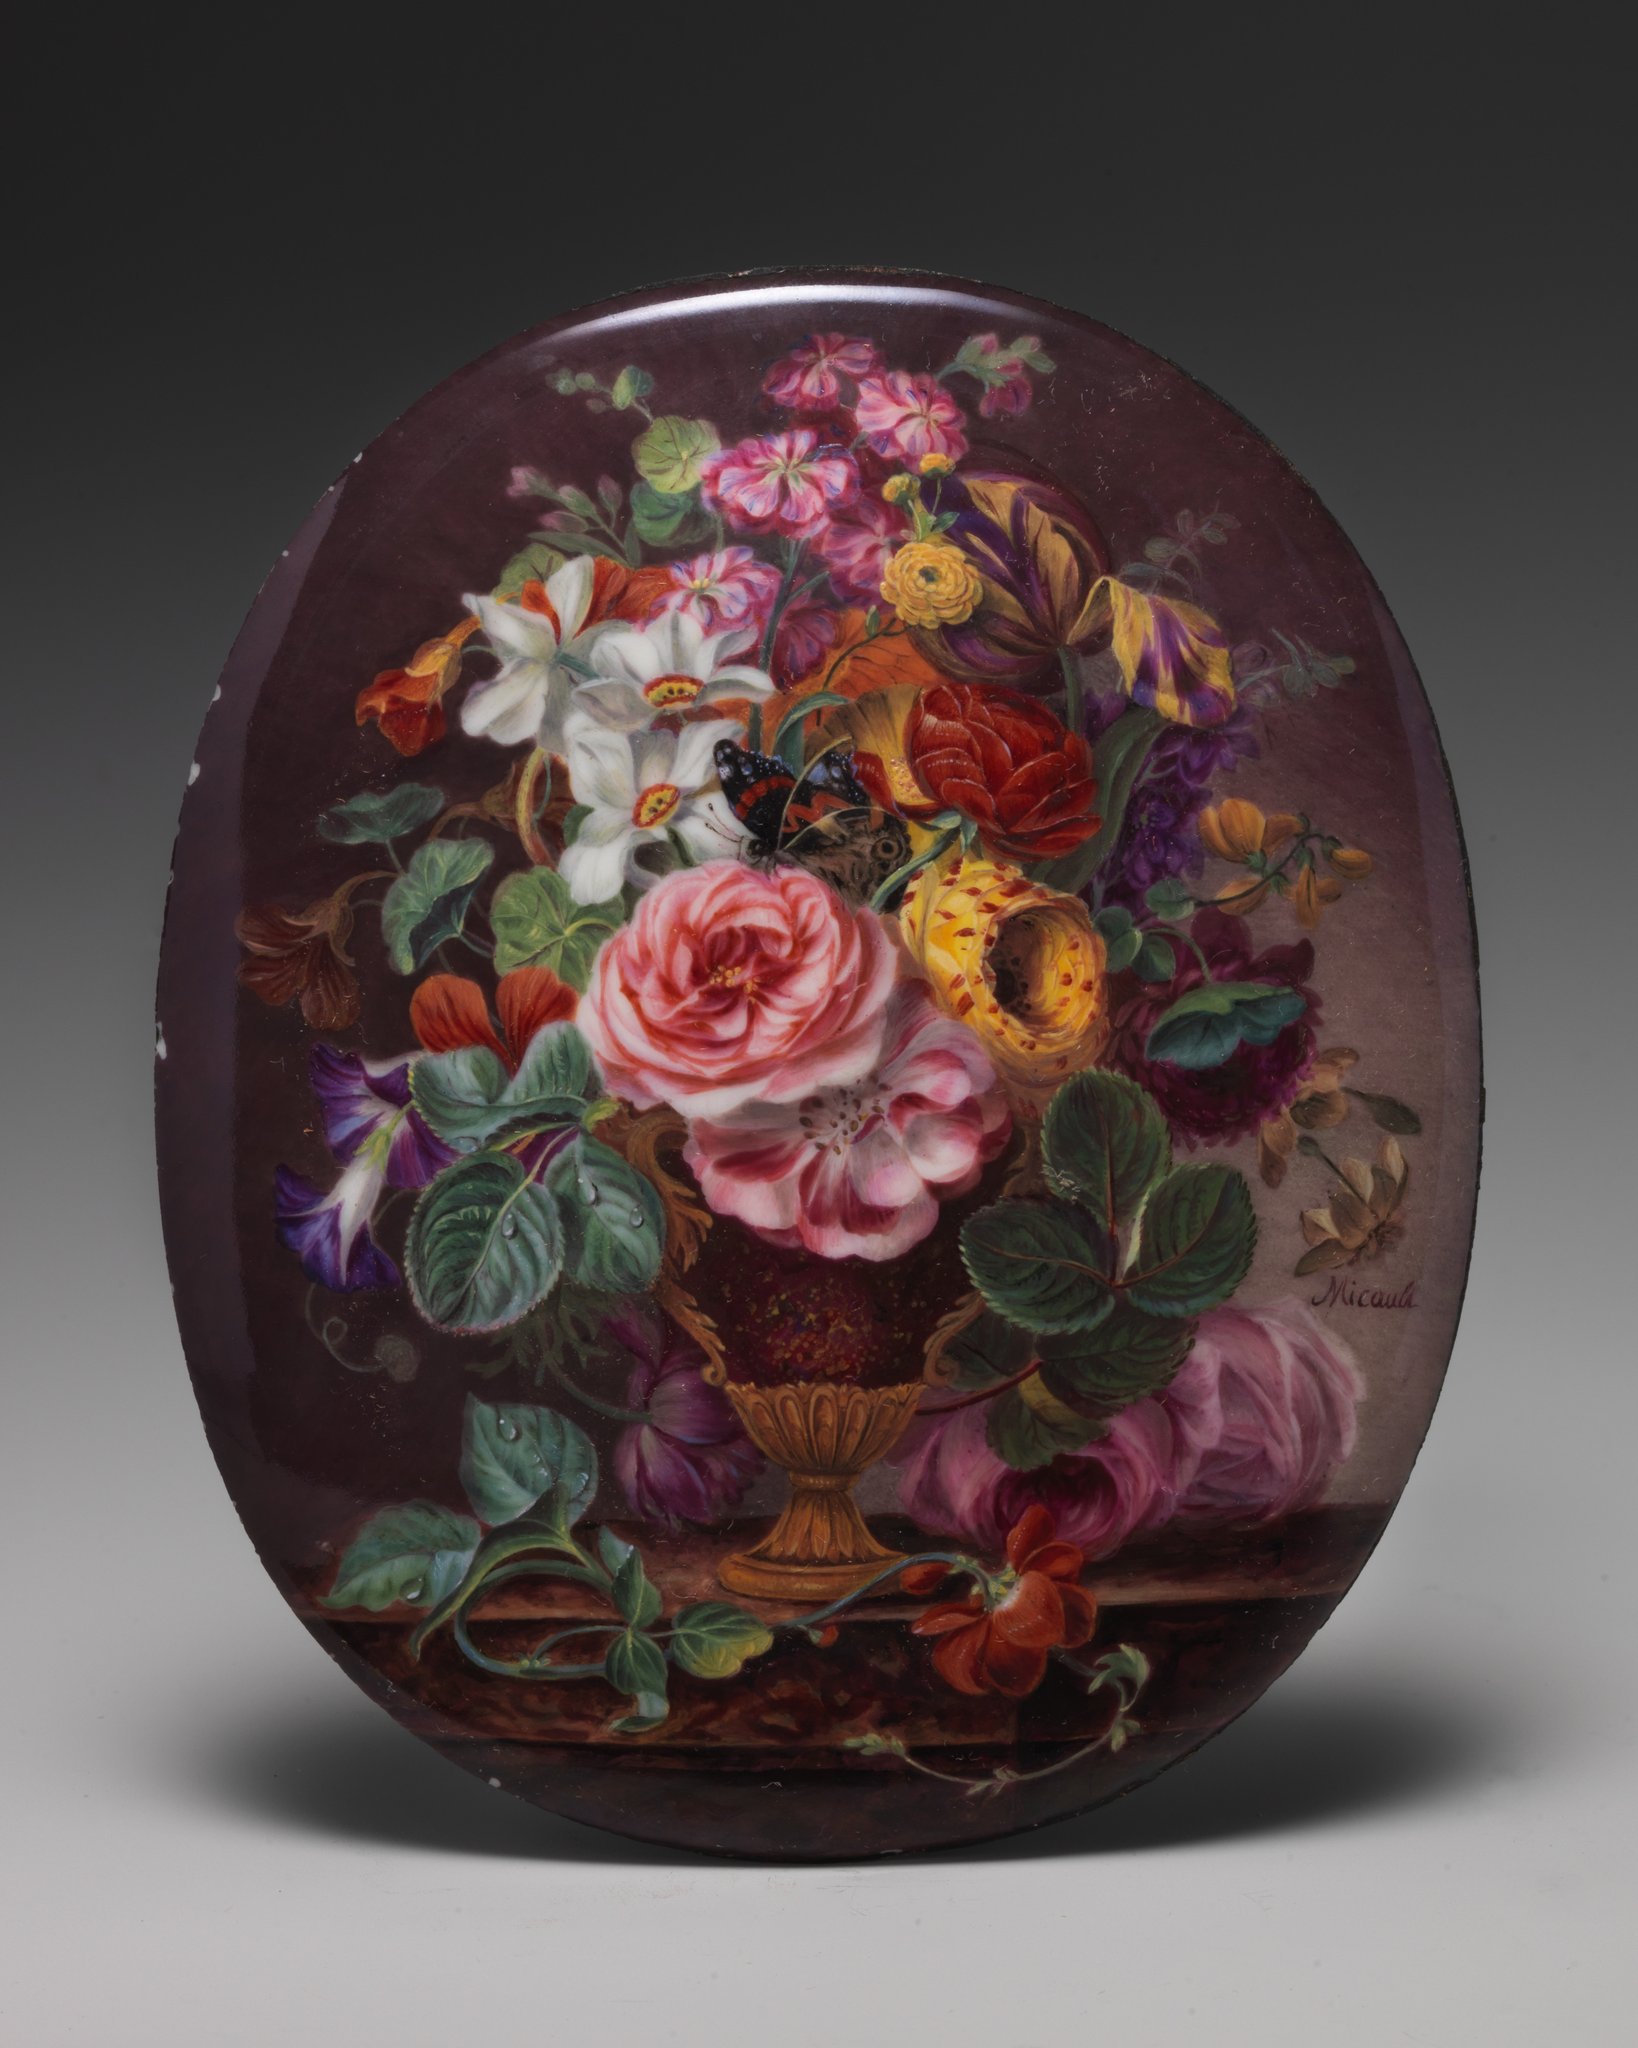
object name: plaque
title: Plaque (one of two)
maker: micault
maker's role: maker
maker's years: 1725-1825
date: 1751-1800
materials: copper, enamel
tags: butterflies,roses,leaves